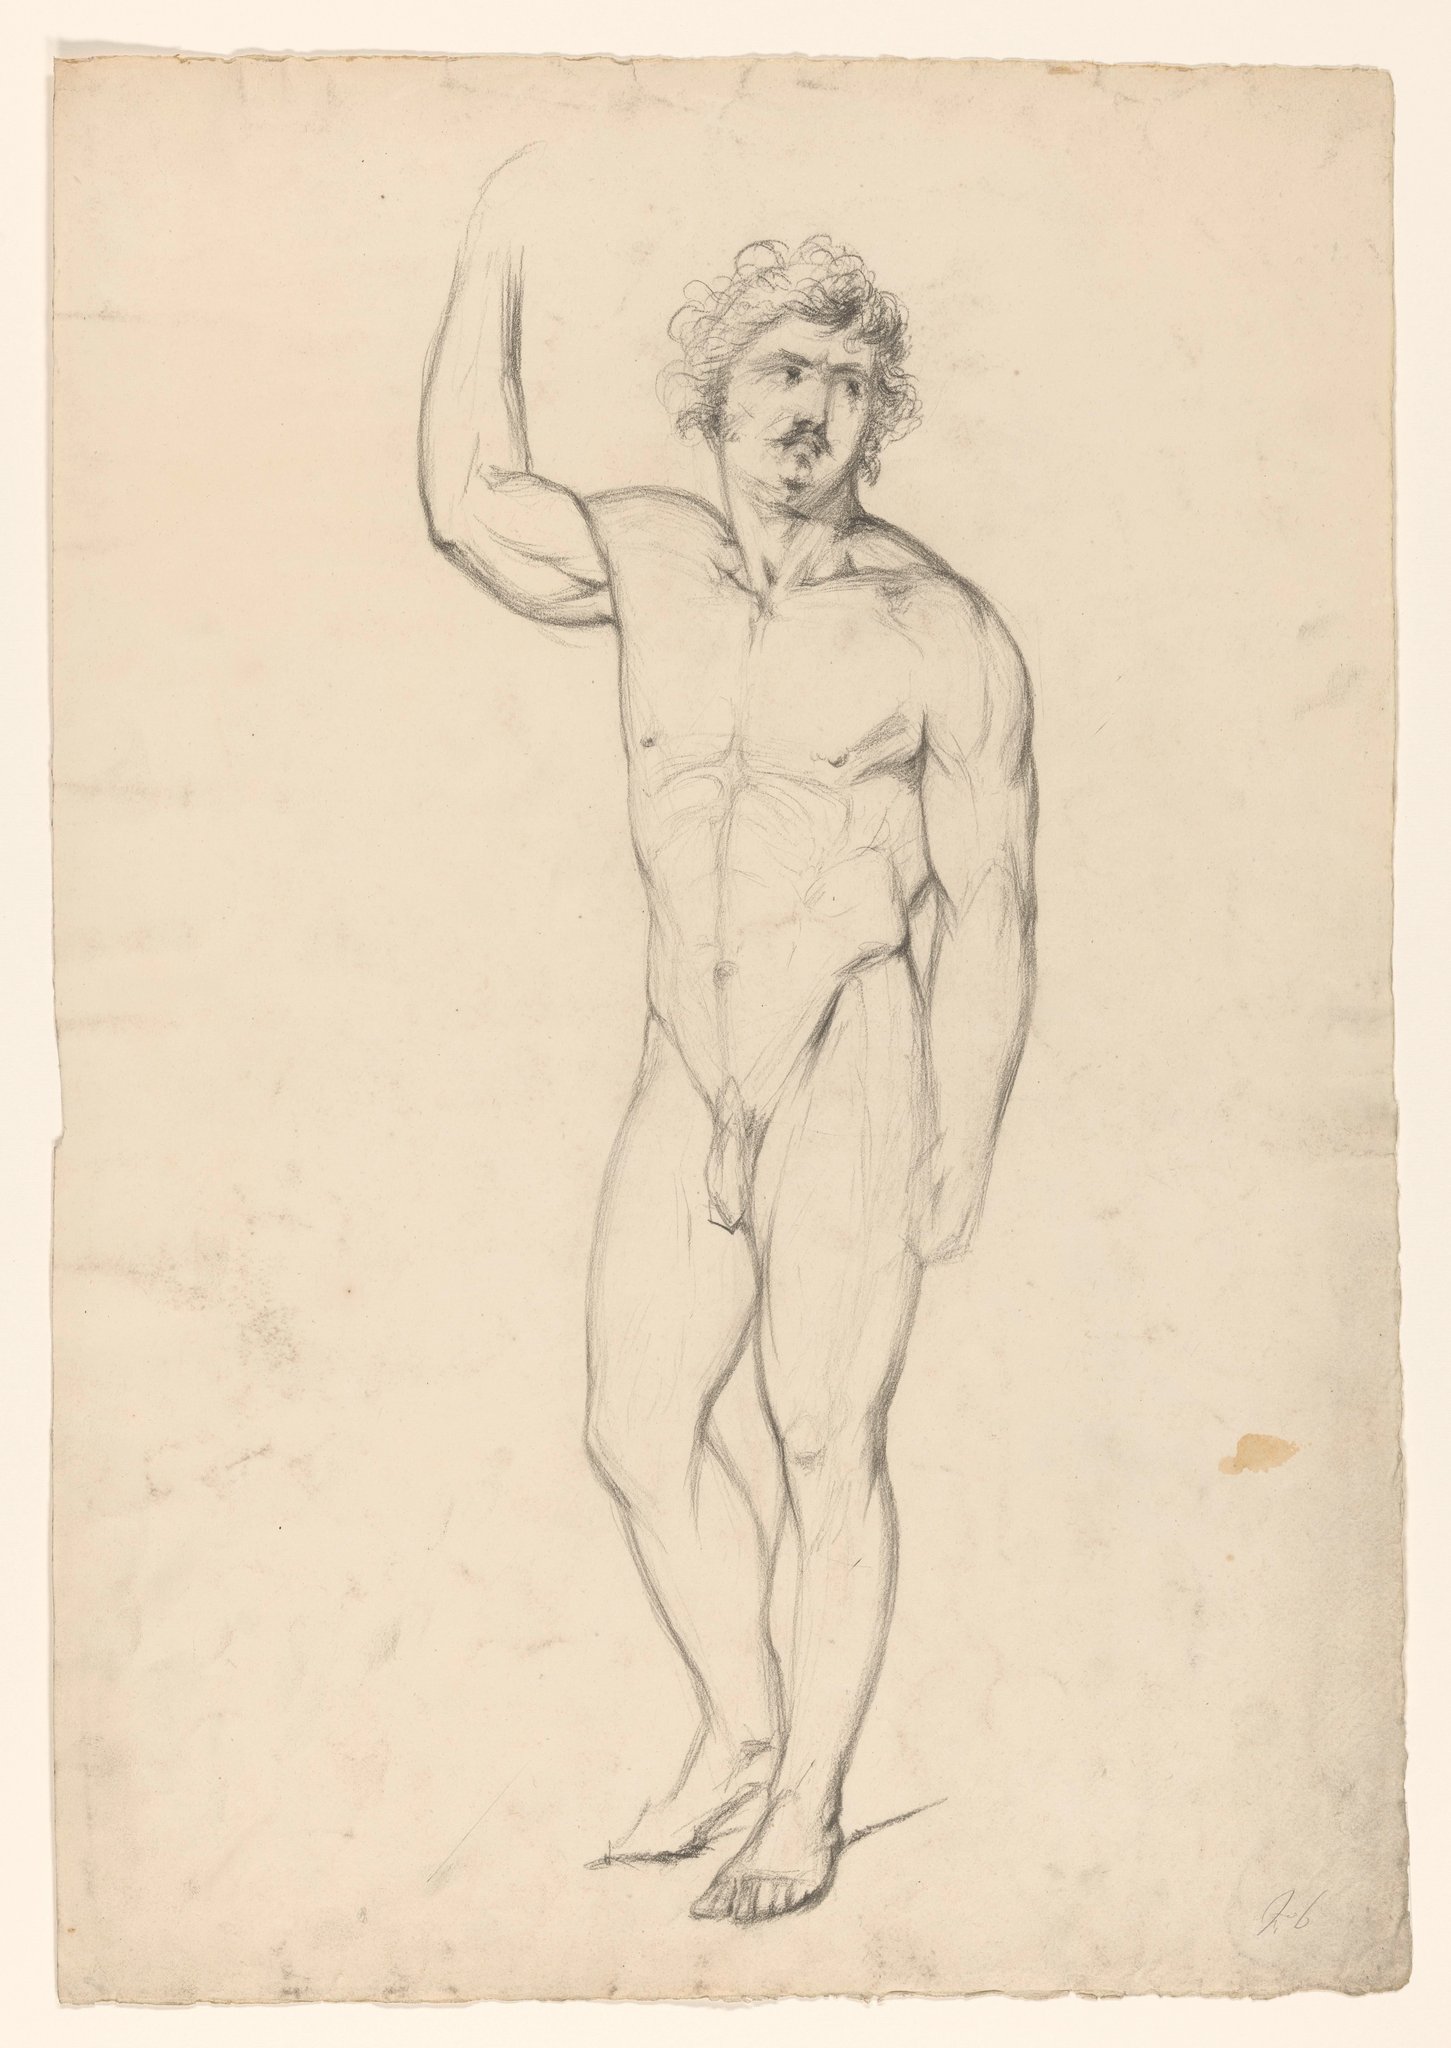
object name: drawing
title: Staand mannelijk naakt, van voren gezien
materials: chalk, paper